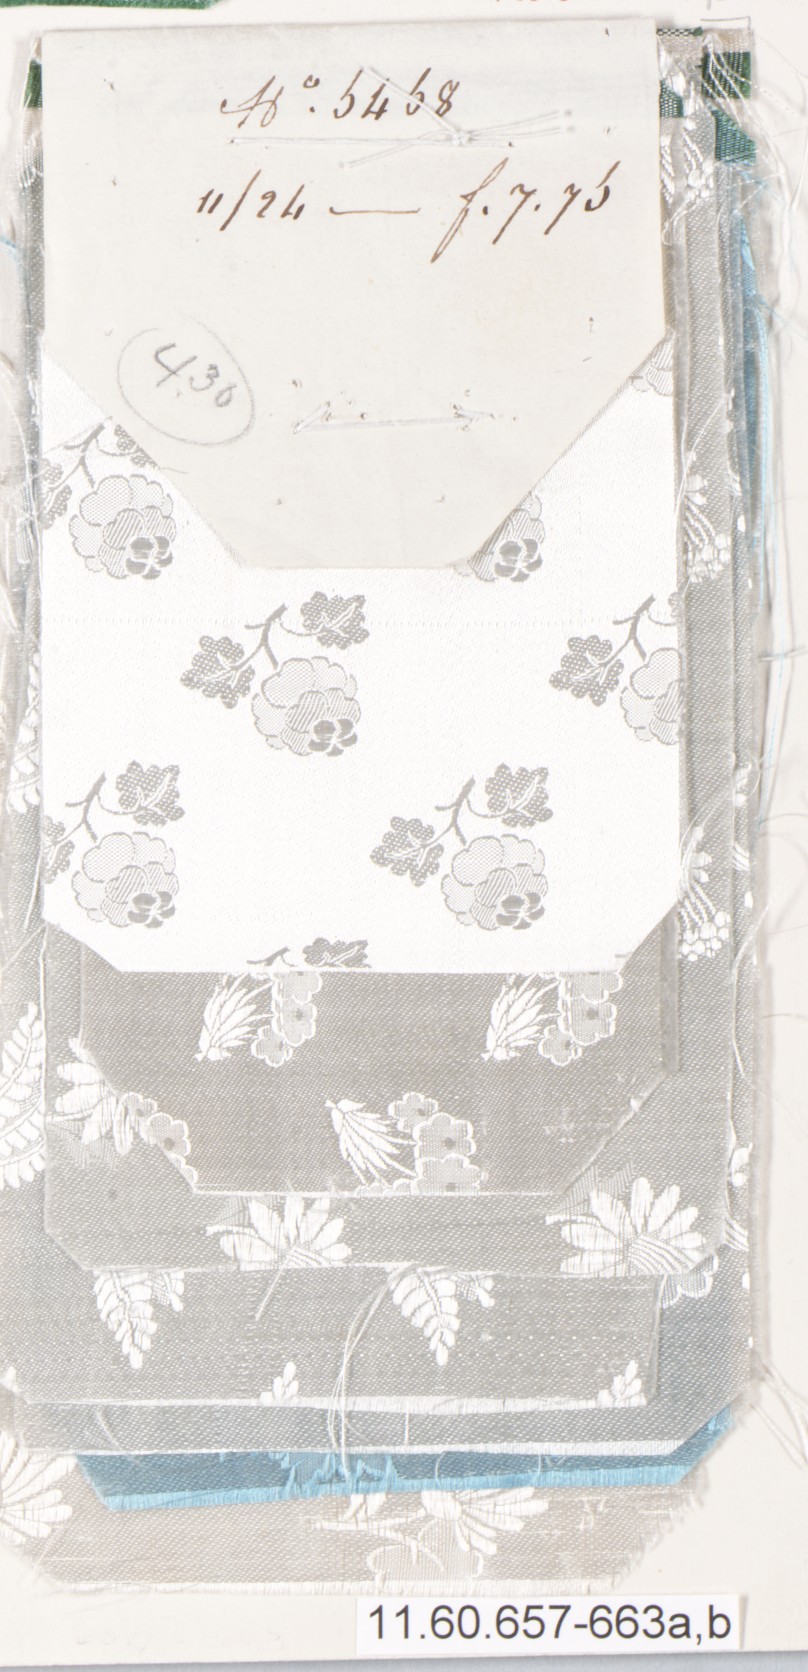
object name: sample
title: Samples (6)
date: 1801-1833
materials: silk